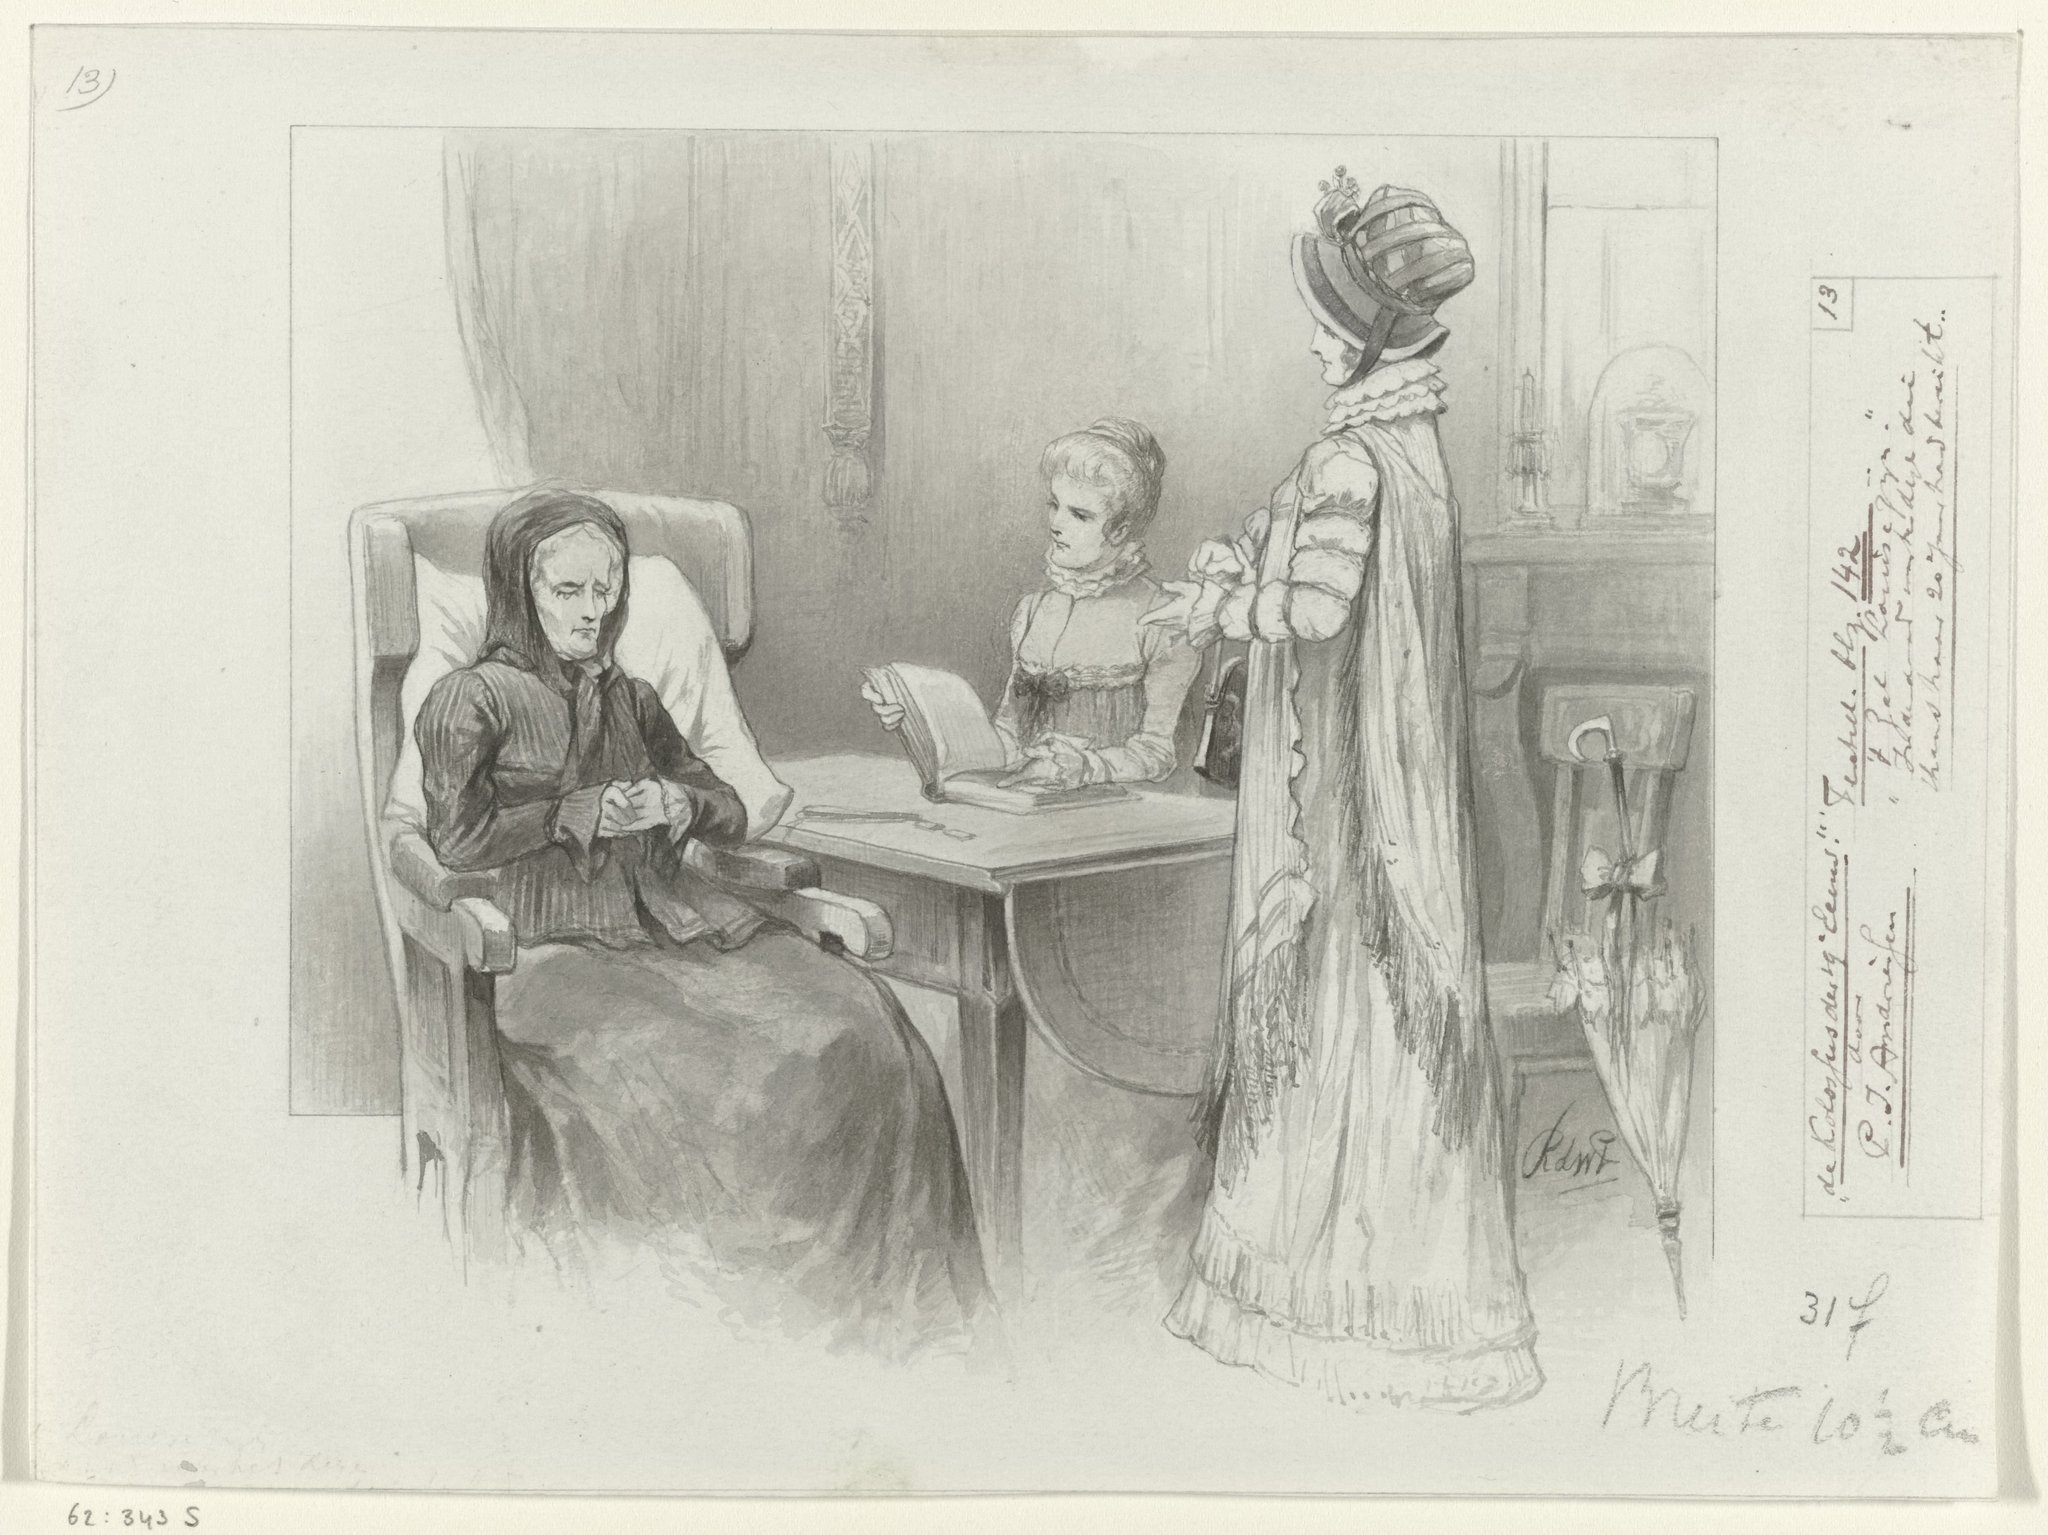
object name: drawing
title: Ontwerp voor illustratie voor De Kolossus der Negentiende Eeuw door P.J. Andriessen (Textill., blz. 142); scène uit het leven van Napoleon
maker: george lodewijk de wetstein pfister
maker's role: draughtsman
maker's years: 1867-1942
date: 1877-1942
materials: ink, paper, pencil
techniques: brush, pen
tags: napoleon i (emperor of the french), (andriessen, de kolossus der negentiende eeuw) specific works of literature (with author, title), historical persons, illustration ~ printed matter, book, historical events and situations